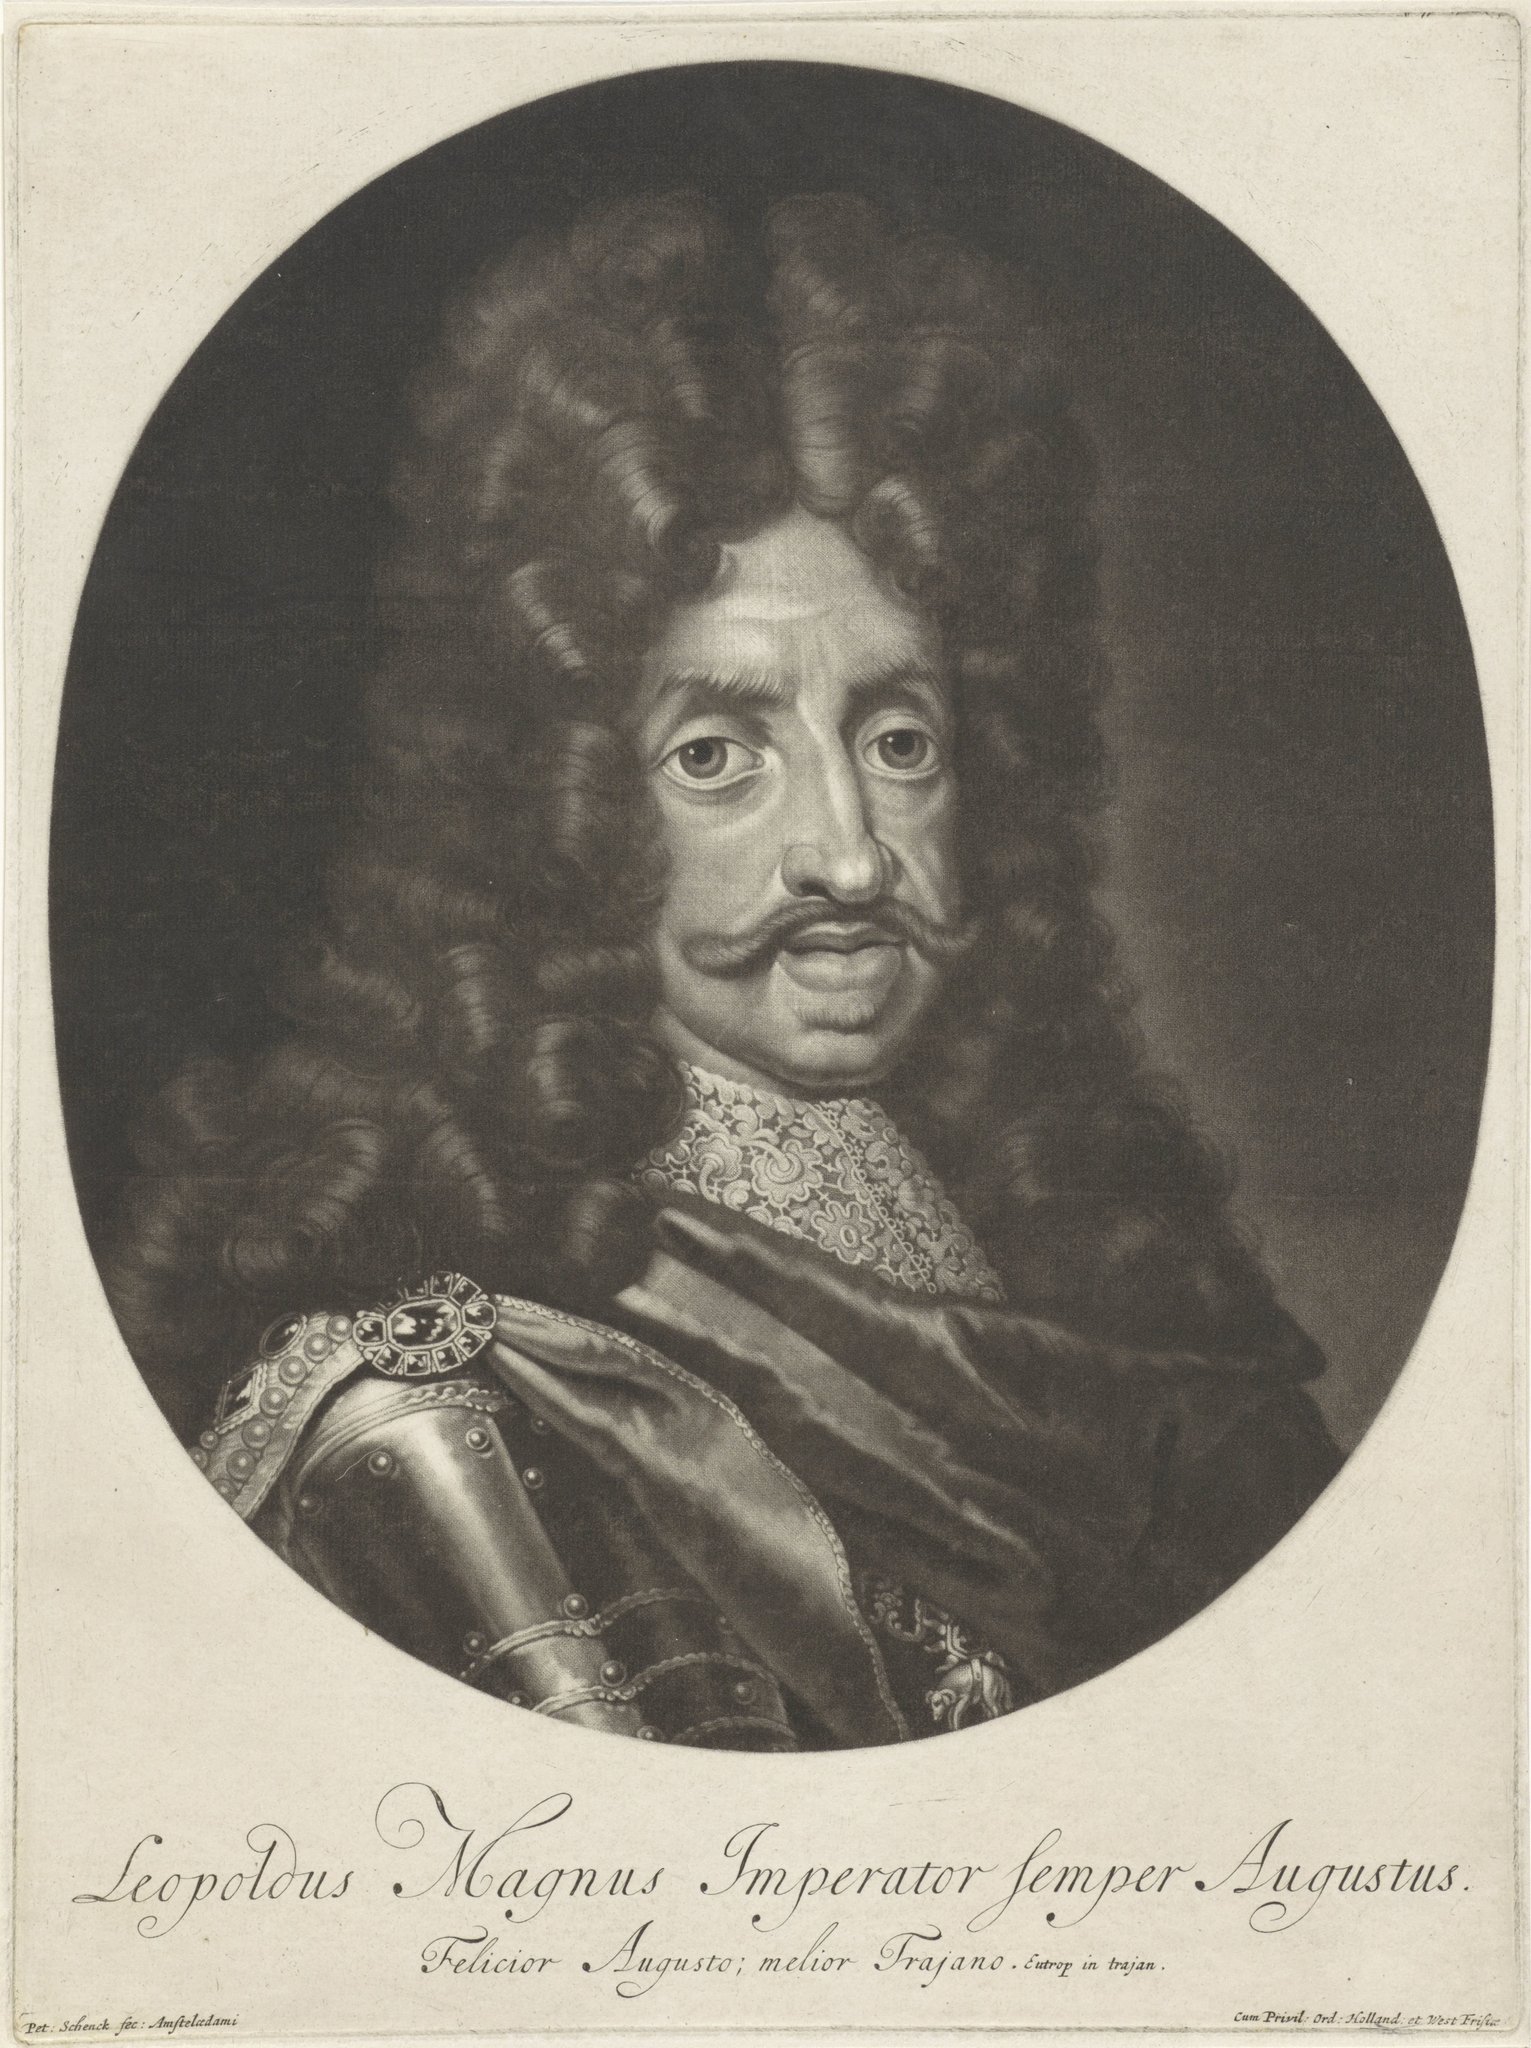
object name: print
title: Portret van keizer Leopold I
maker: pieter schenk (i)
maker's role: print maker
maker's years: 1660-1711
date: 1670-1713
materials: paper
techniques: engraving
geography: amsterdam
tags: vienna, leopold i (keizer van duitsland), armour, knighthood order of the golden fleece, wig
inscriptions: collector's mark: Lugt 2228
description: Portret van Leopold I, keizer van het Heilig Roomse Rijk, aartshertog van Oostenrijk en koning van Hongarije. Hij draagt een harnas en heeft om zijn hals een keten met het ordeteken van het Gulden Vlies. De prent heeft een Latijns onderschrift met de naam en de titels van de geportretteerde.